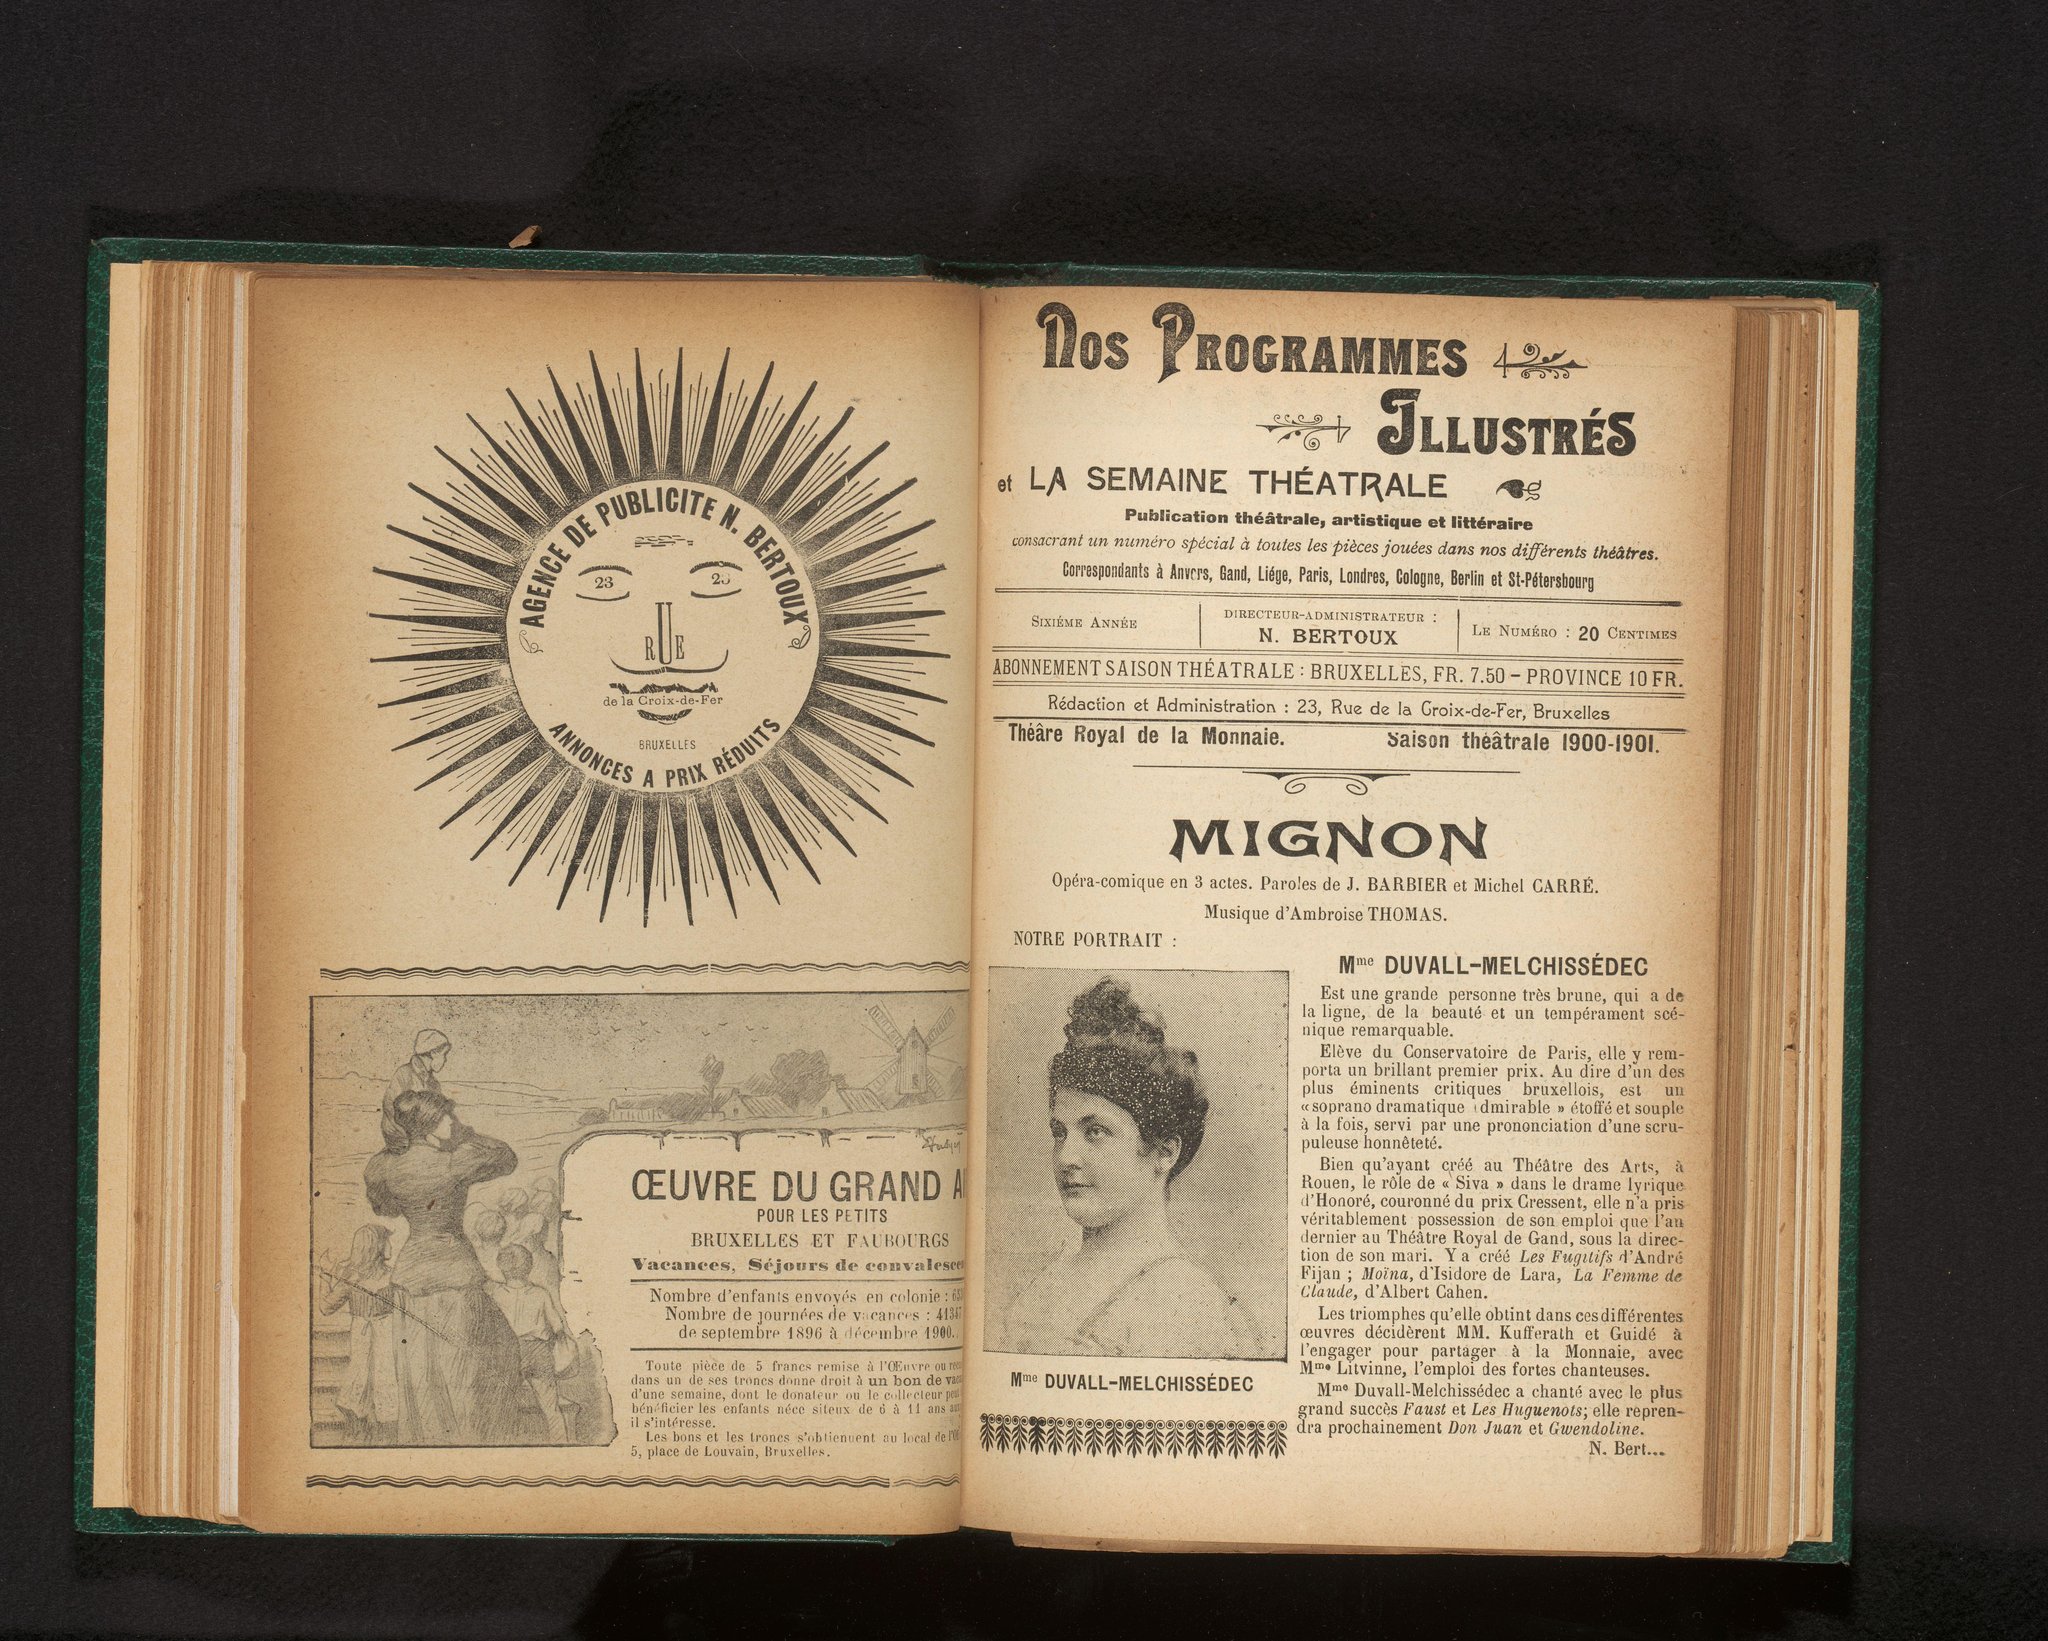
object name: page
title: Mme Duvall-Melchisédech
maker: Anonymous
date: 1895-1900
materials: paper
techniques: photograph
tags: adult woman, historical persons